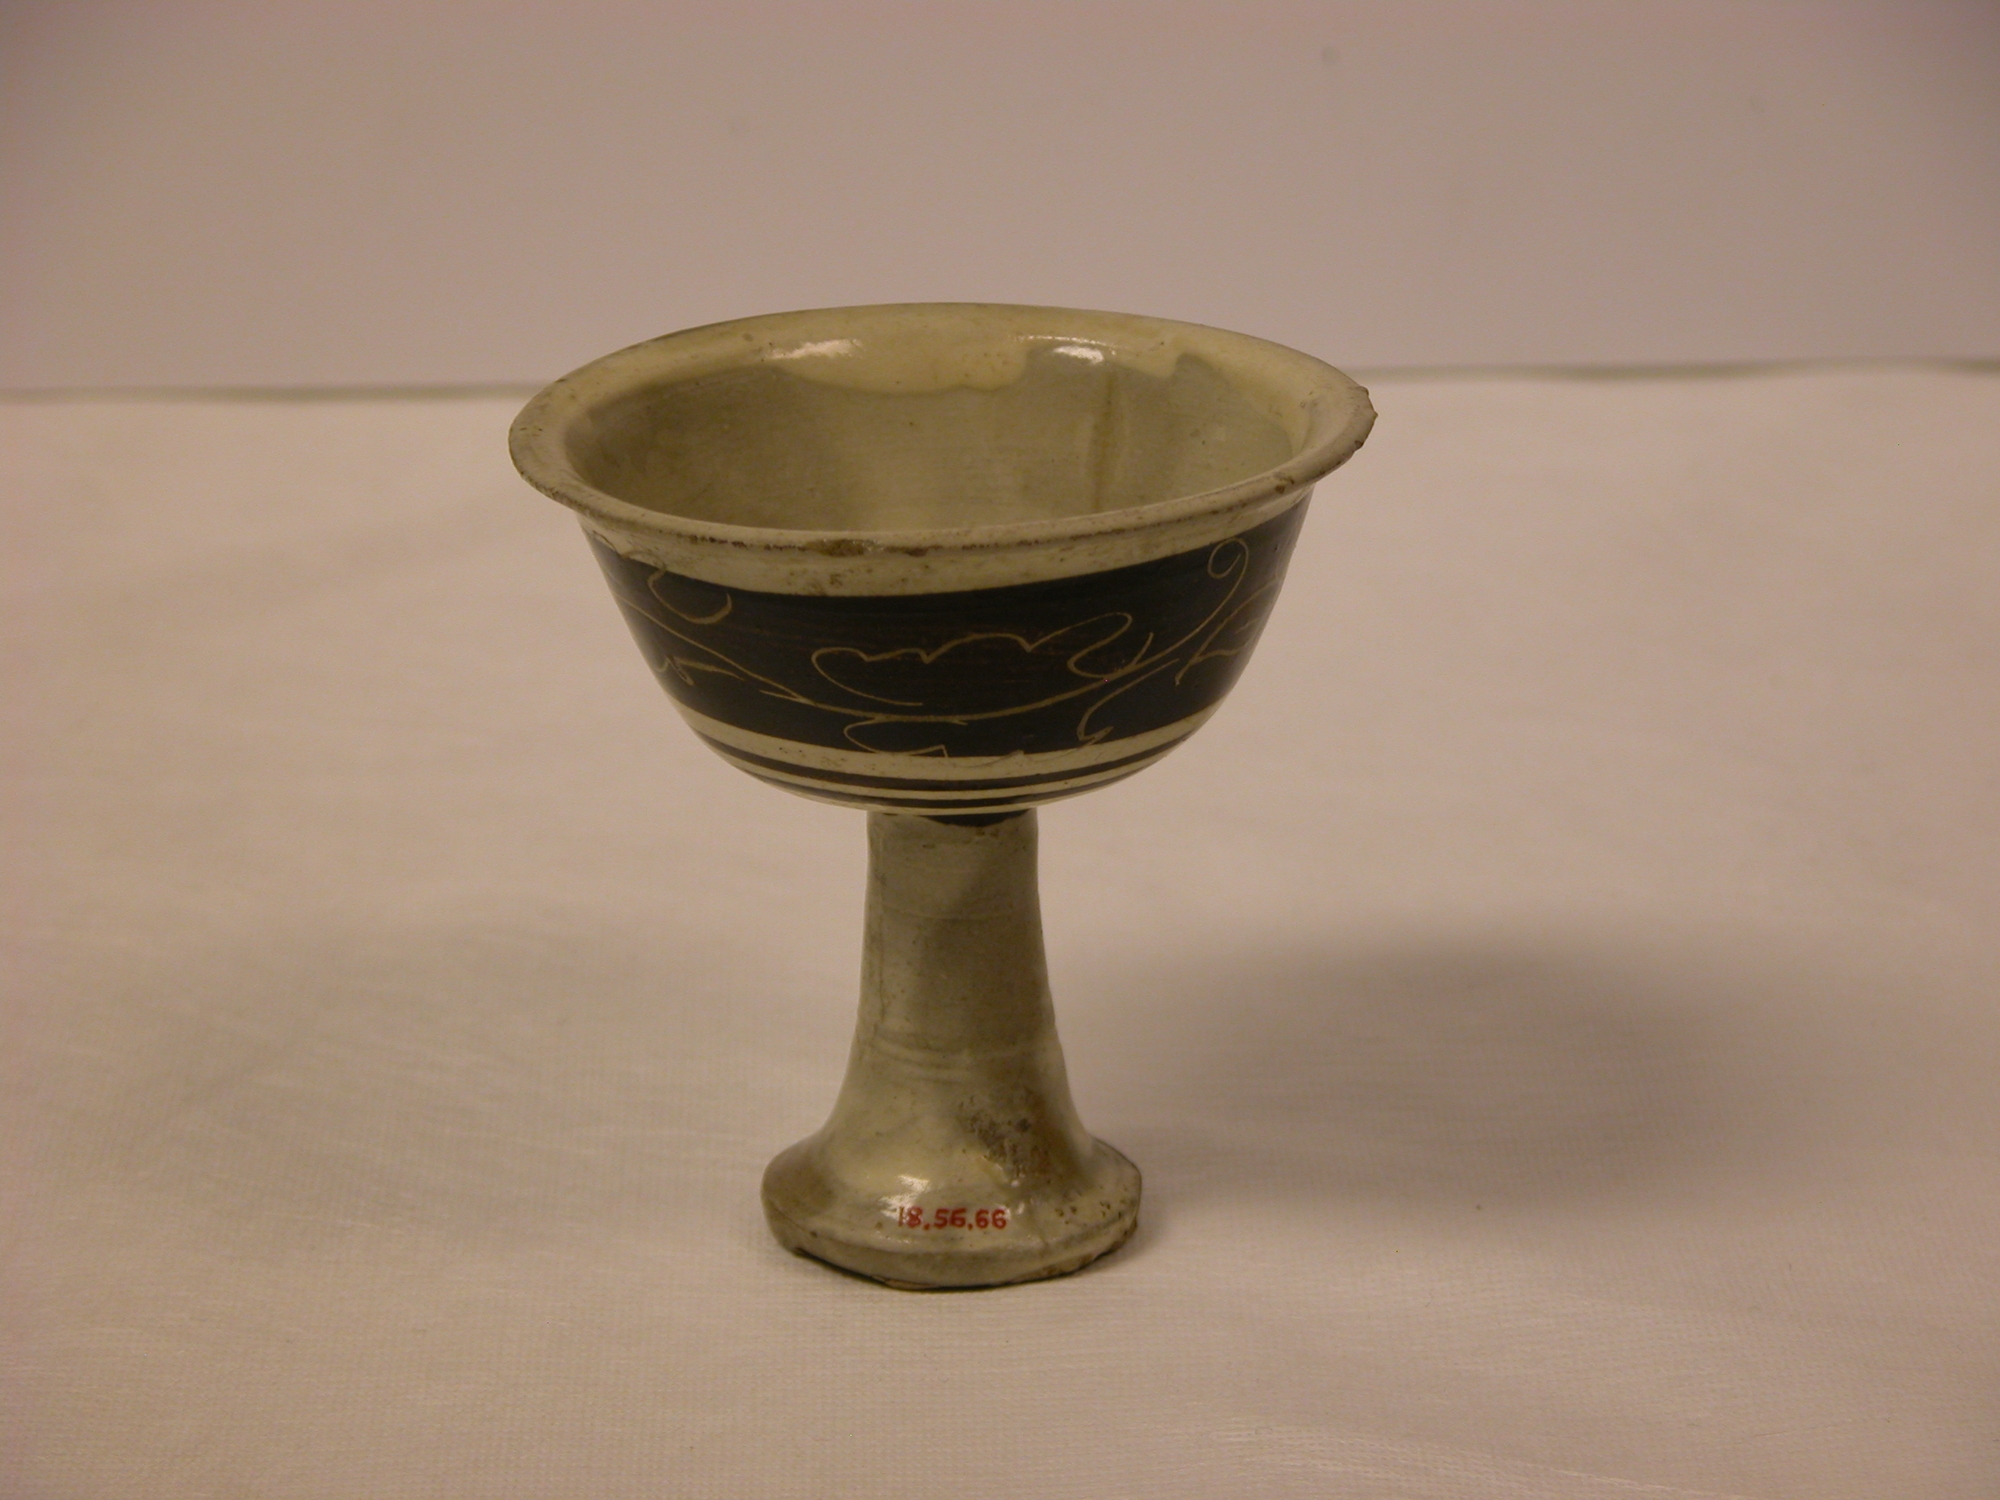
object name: cup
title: Cup on High Foot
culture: chinese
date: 1368-1644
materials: pottery